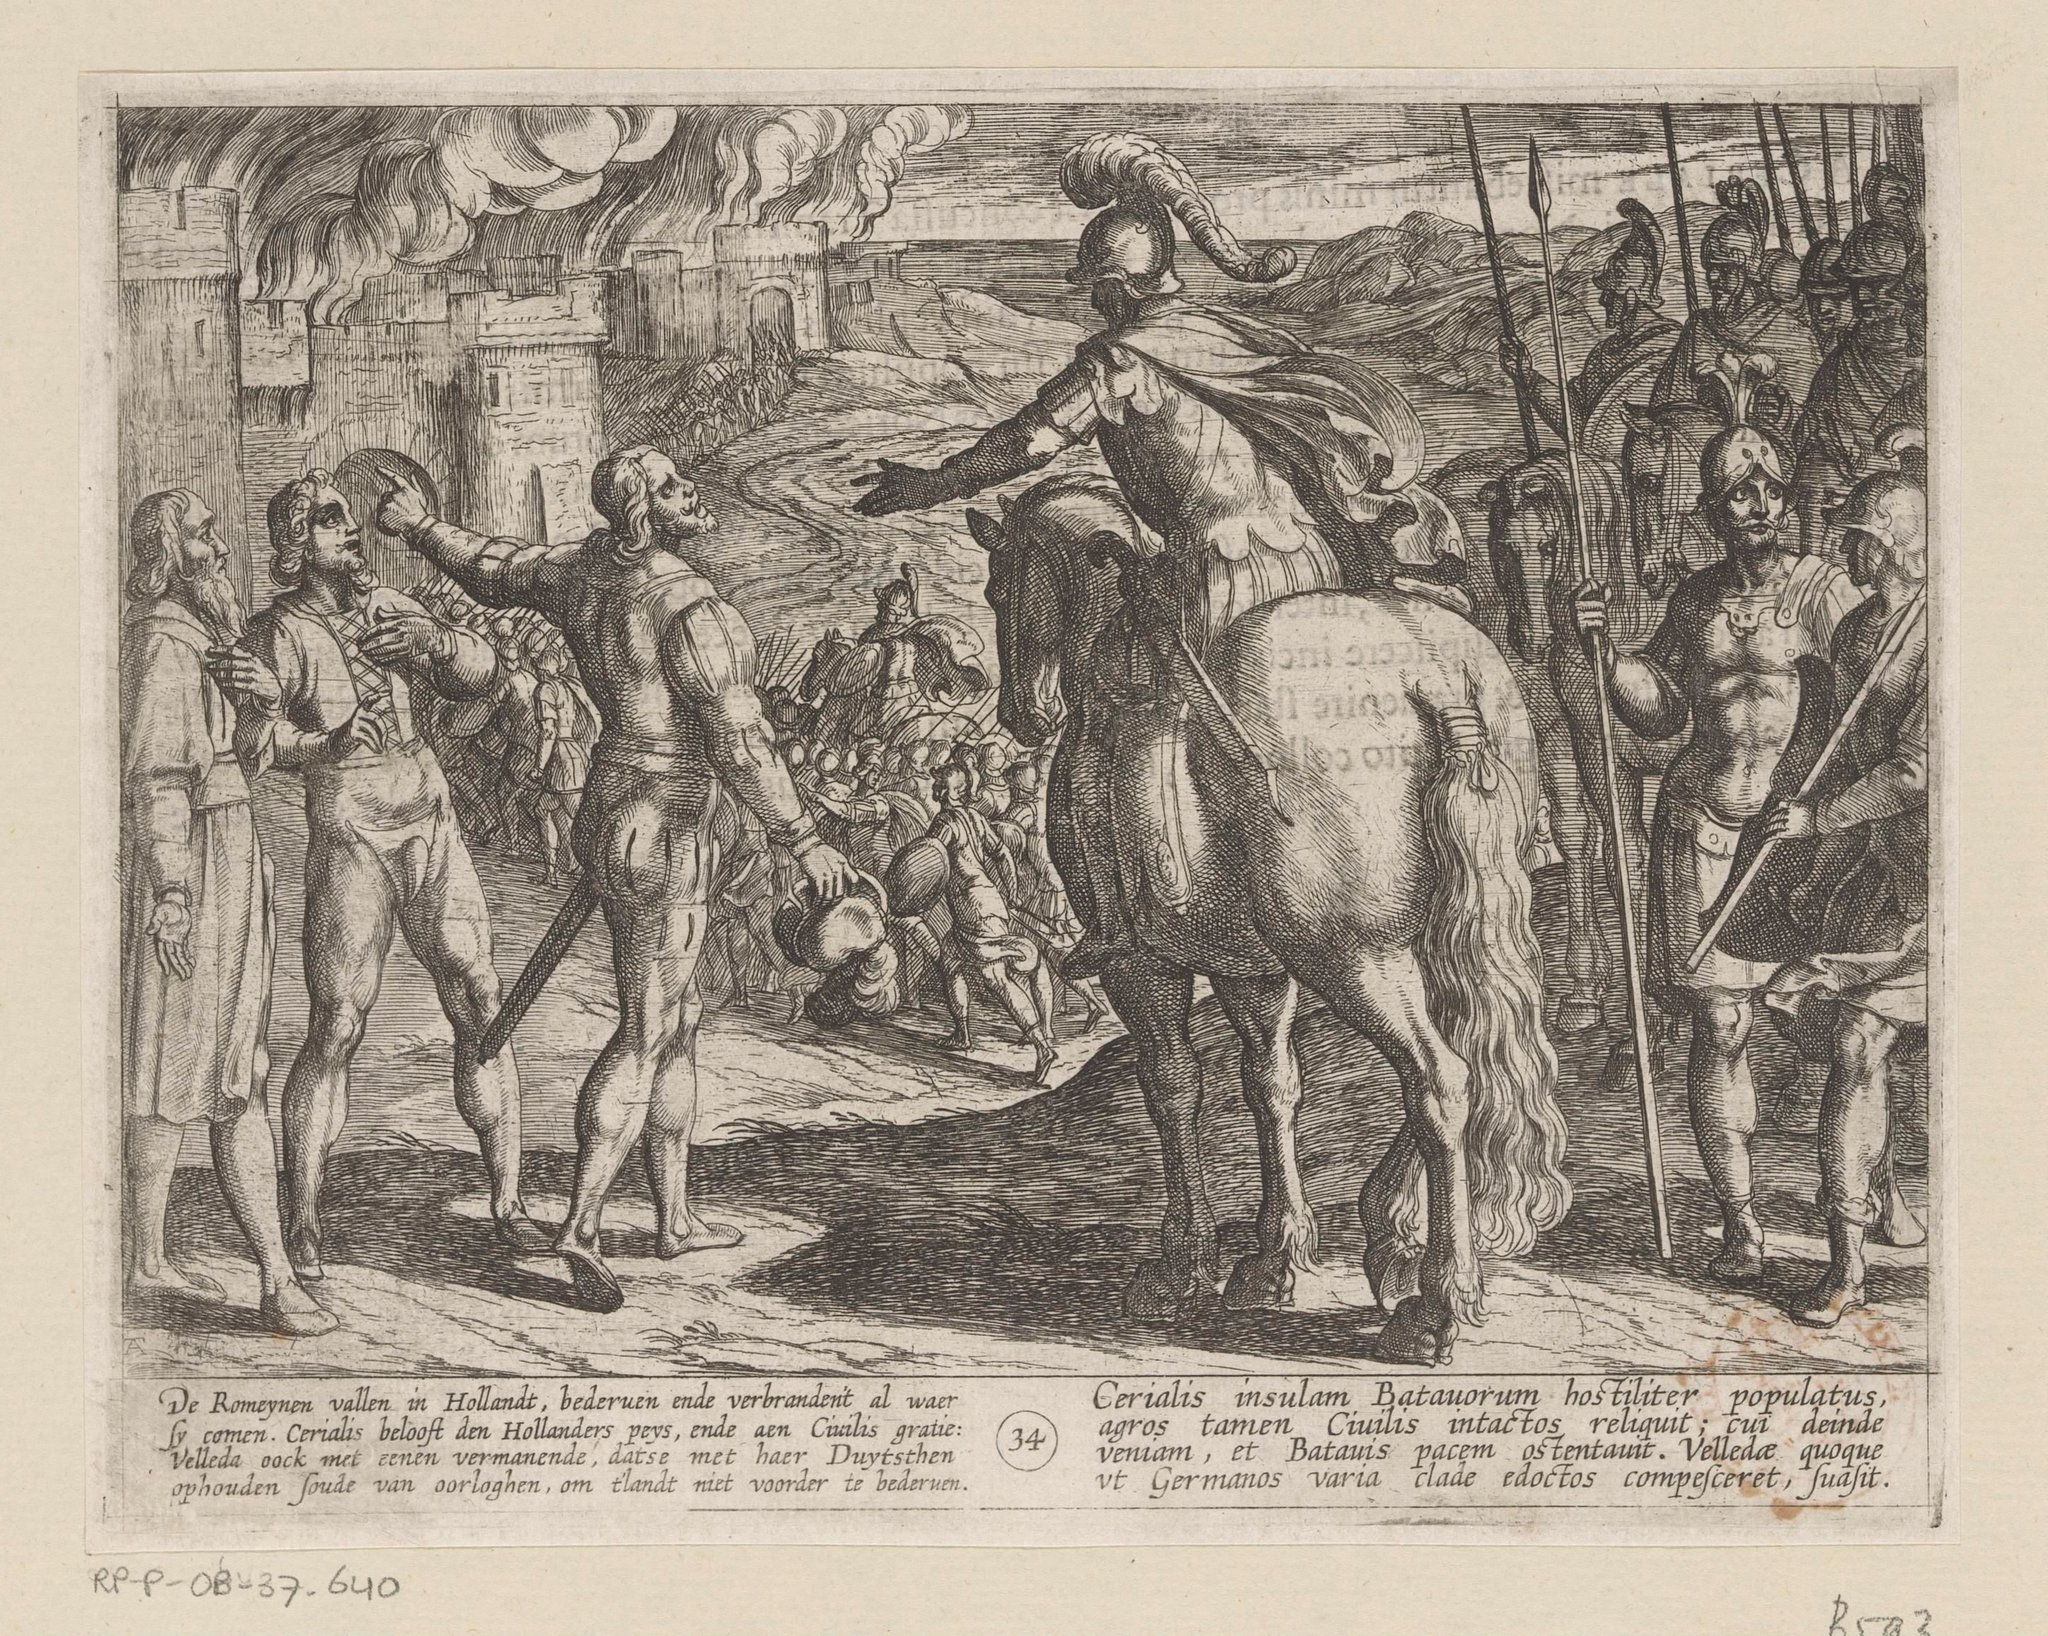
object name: print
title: De Bataafse oorlogen tegen de Romeinen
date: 1611-1612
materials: paper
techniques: etching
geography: southern netherlands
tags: battle, the soldier; the soldier's life, burning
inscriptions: collector's mark: Lugt 240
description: De Romeinse troepen verbranden Nederlandse nederzettingen op het platteland. Onderschrift in het Nederlands en in het Latijn.